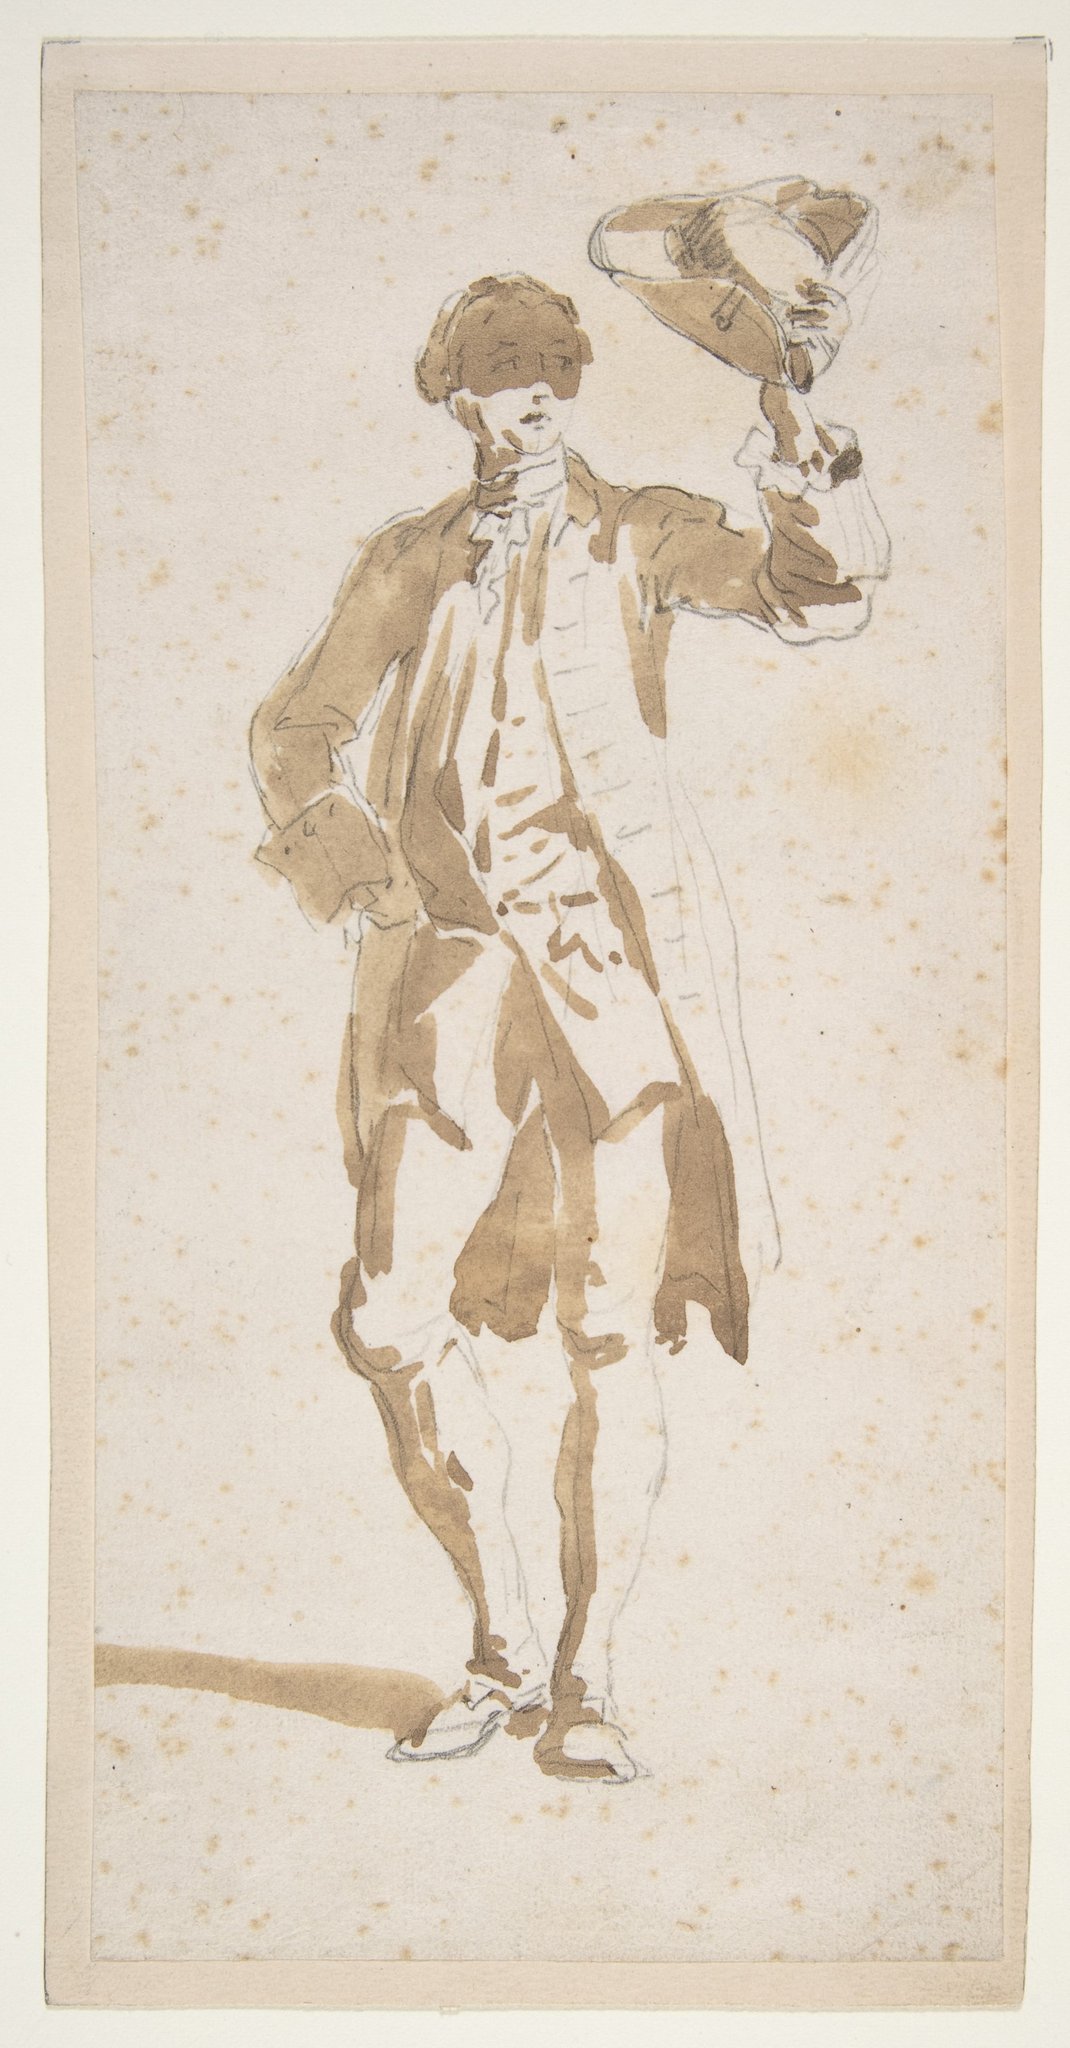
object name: drawing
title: Man Shading His Face with a Tricorne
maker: giovanni paolo panini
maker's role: artist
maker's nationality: italian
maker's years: 1691-1765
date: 1691-1765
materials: graphite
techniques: brush, wash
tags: tricorns,faces,men